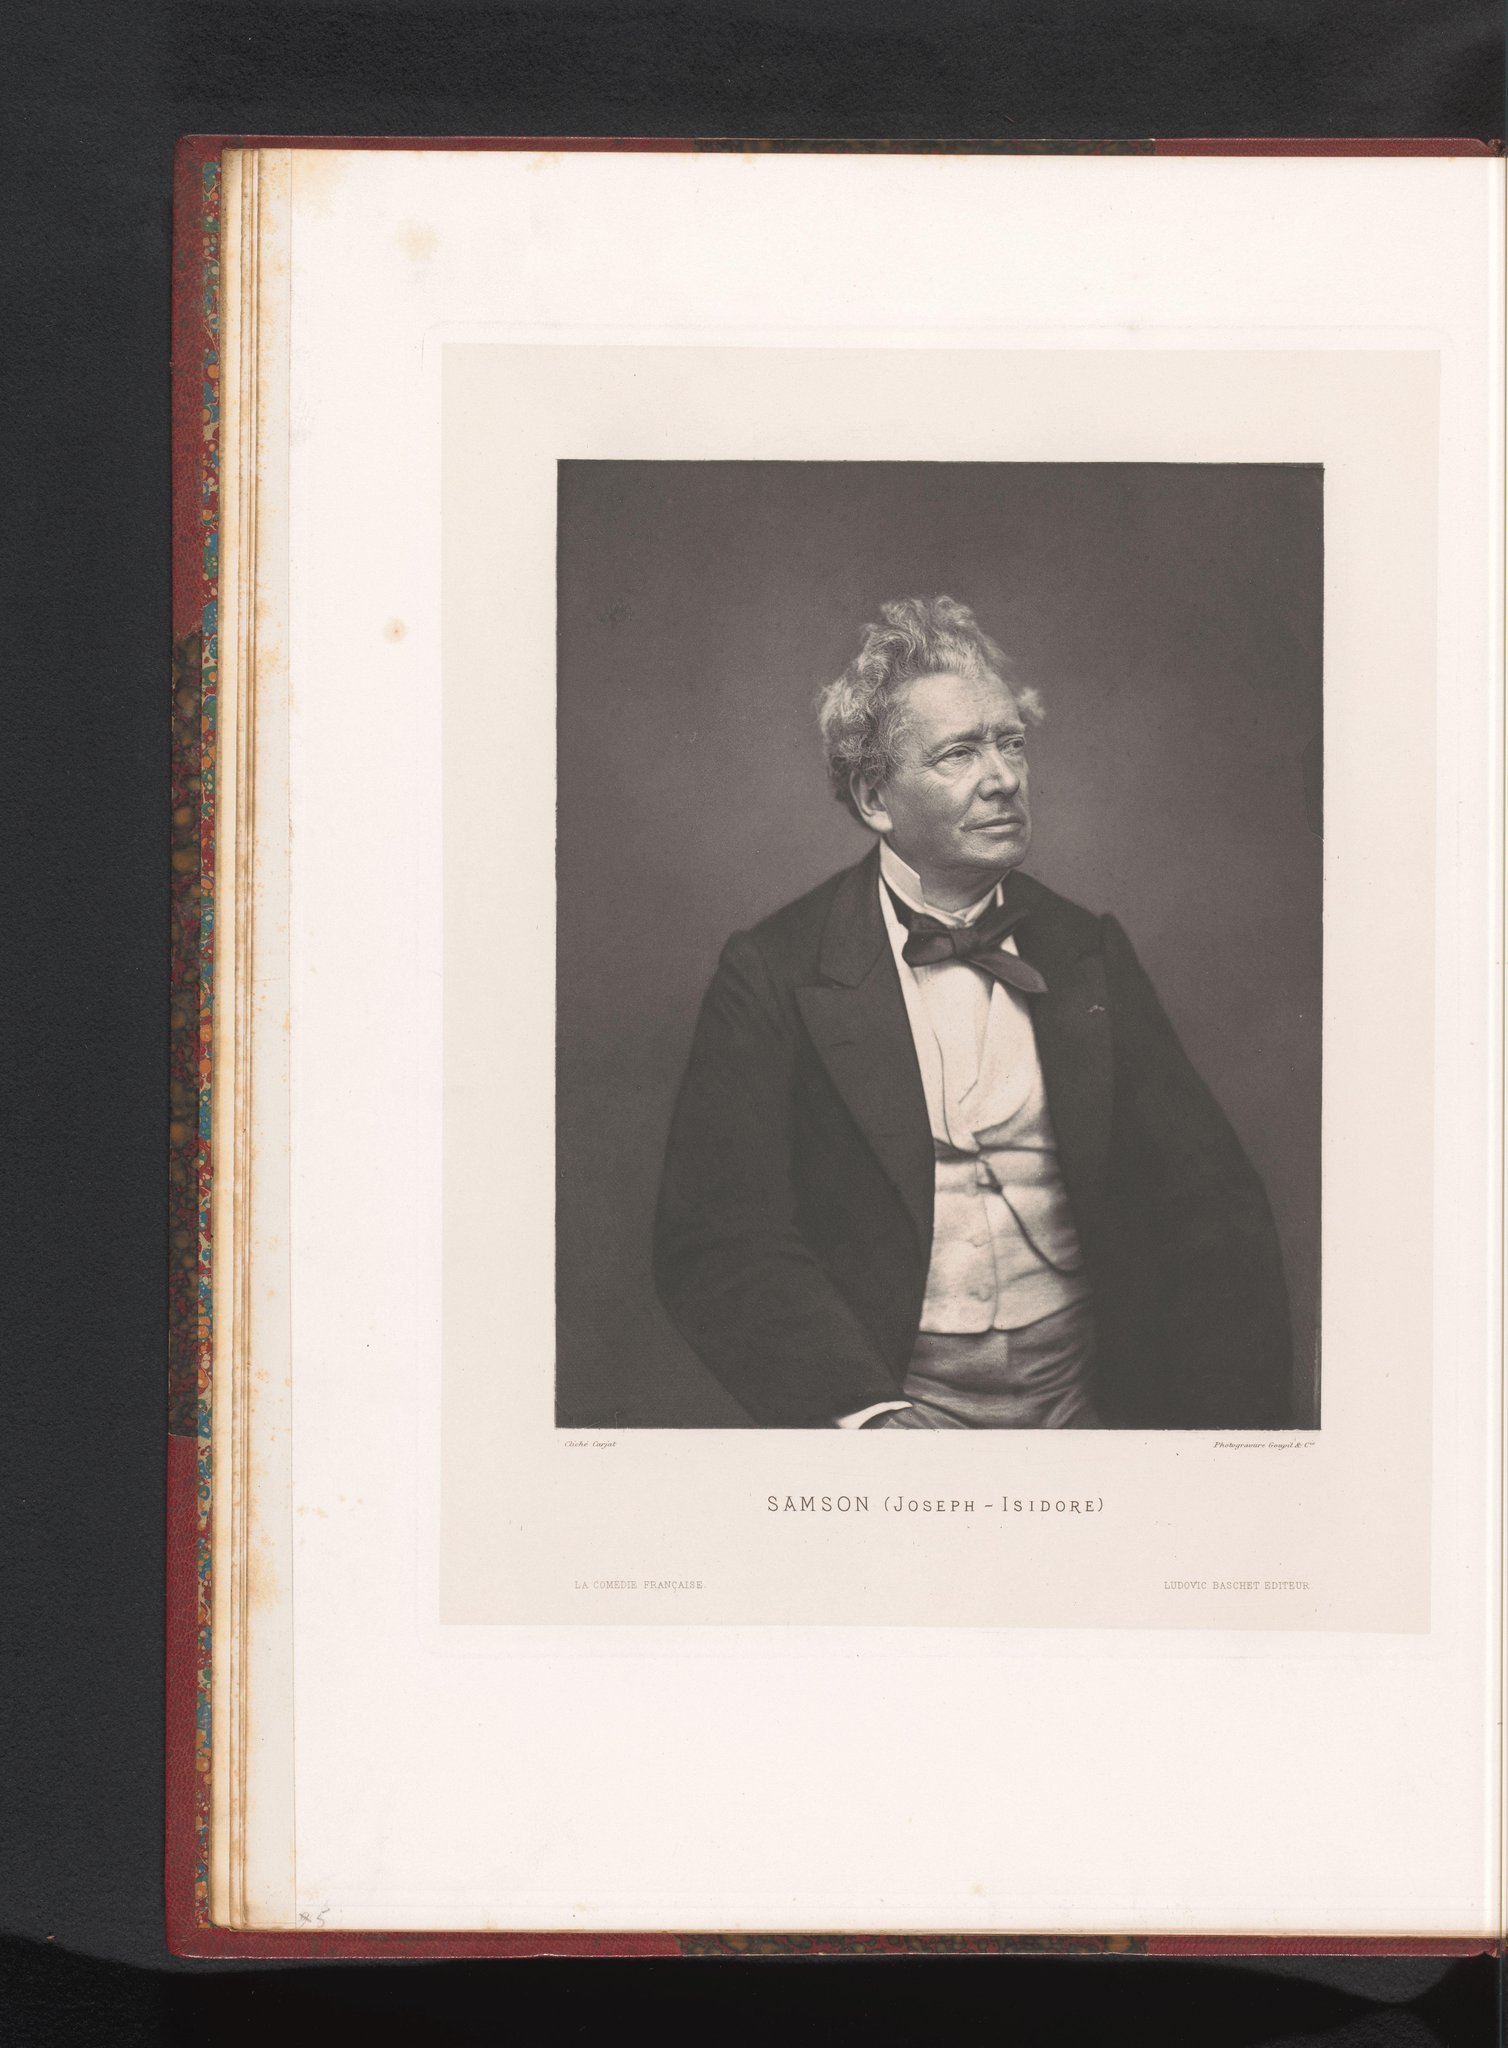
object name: page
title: Samson (Joseph-Isidore)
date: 1875-1880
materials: paper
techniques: photoaquatint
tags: joseph isidore samson, historical persons, portrait of a writer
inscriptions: inscription: ‘LA COMÉDIE FRANÇAISE’, number: ‘5’